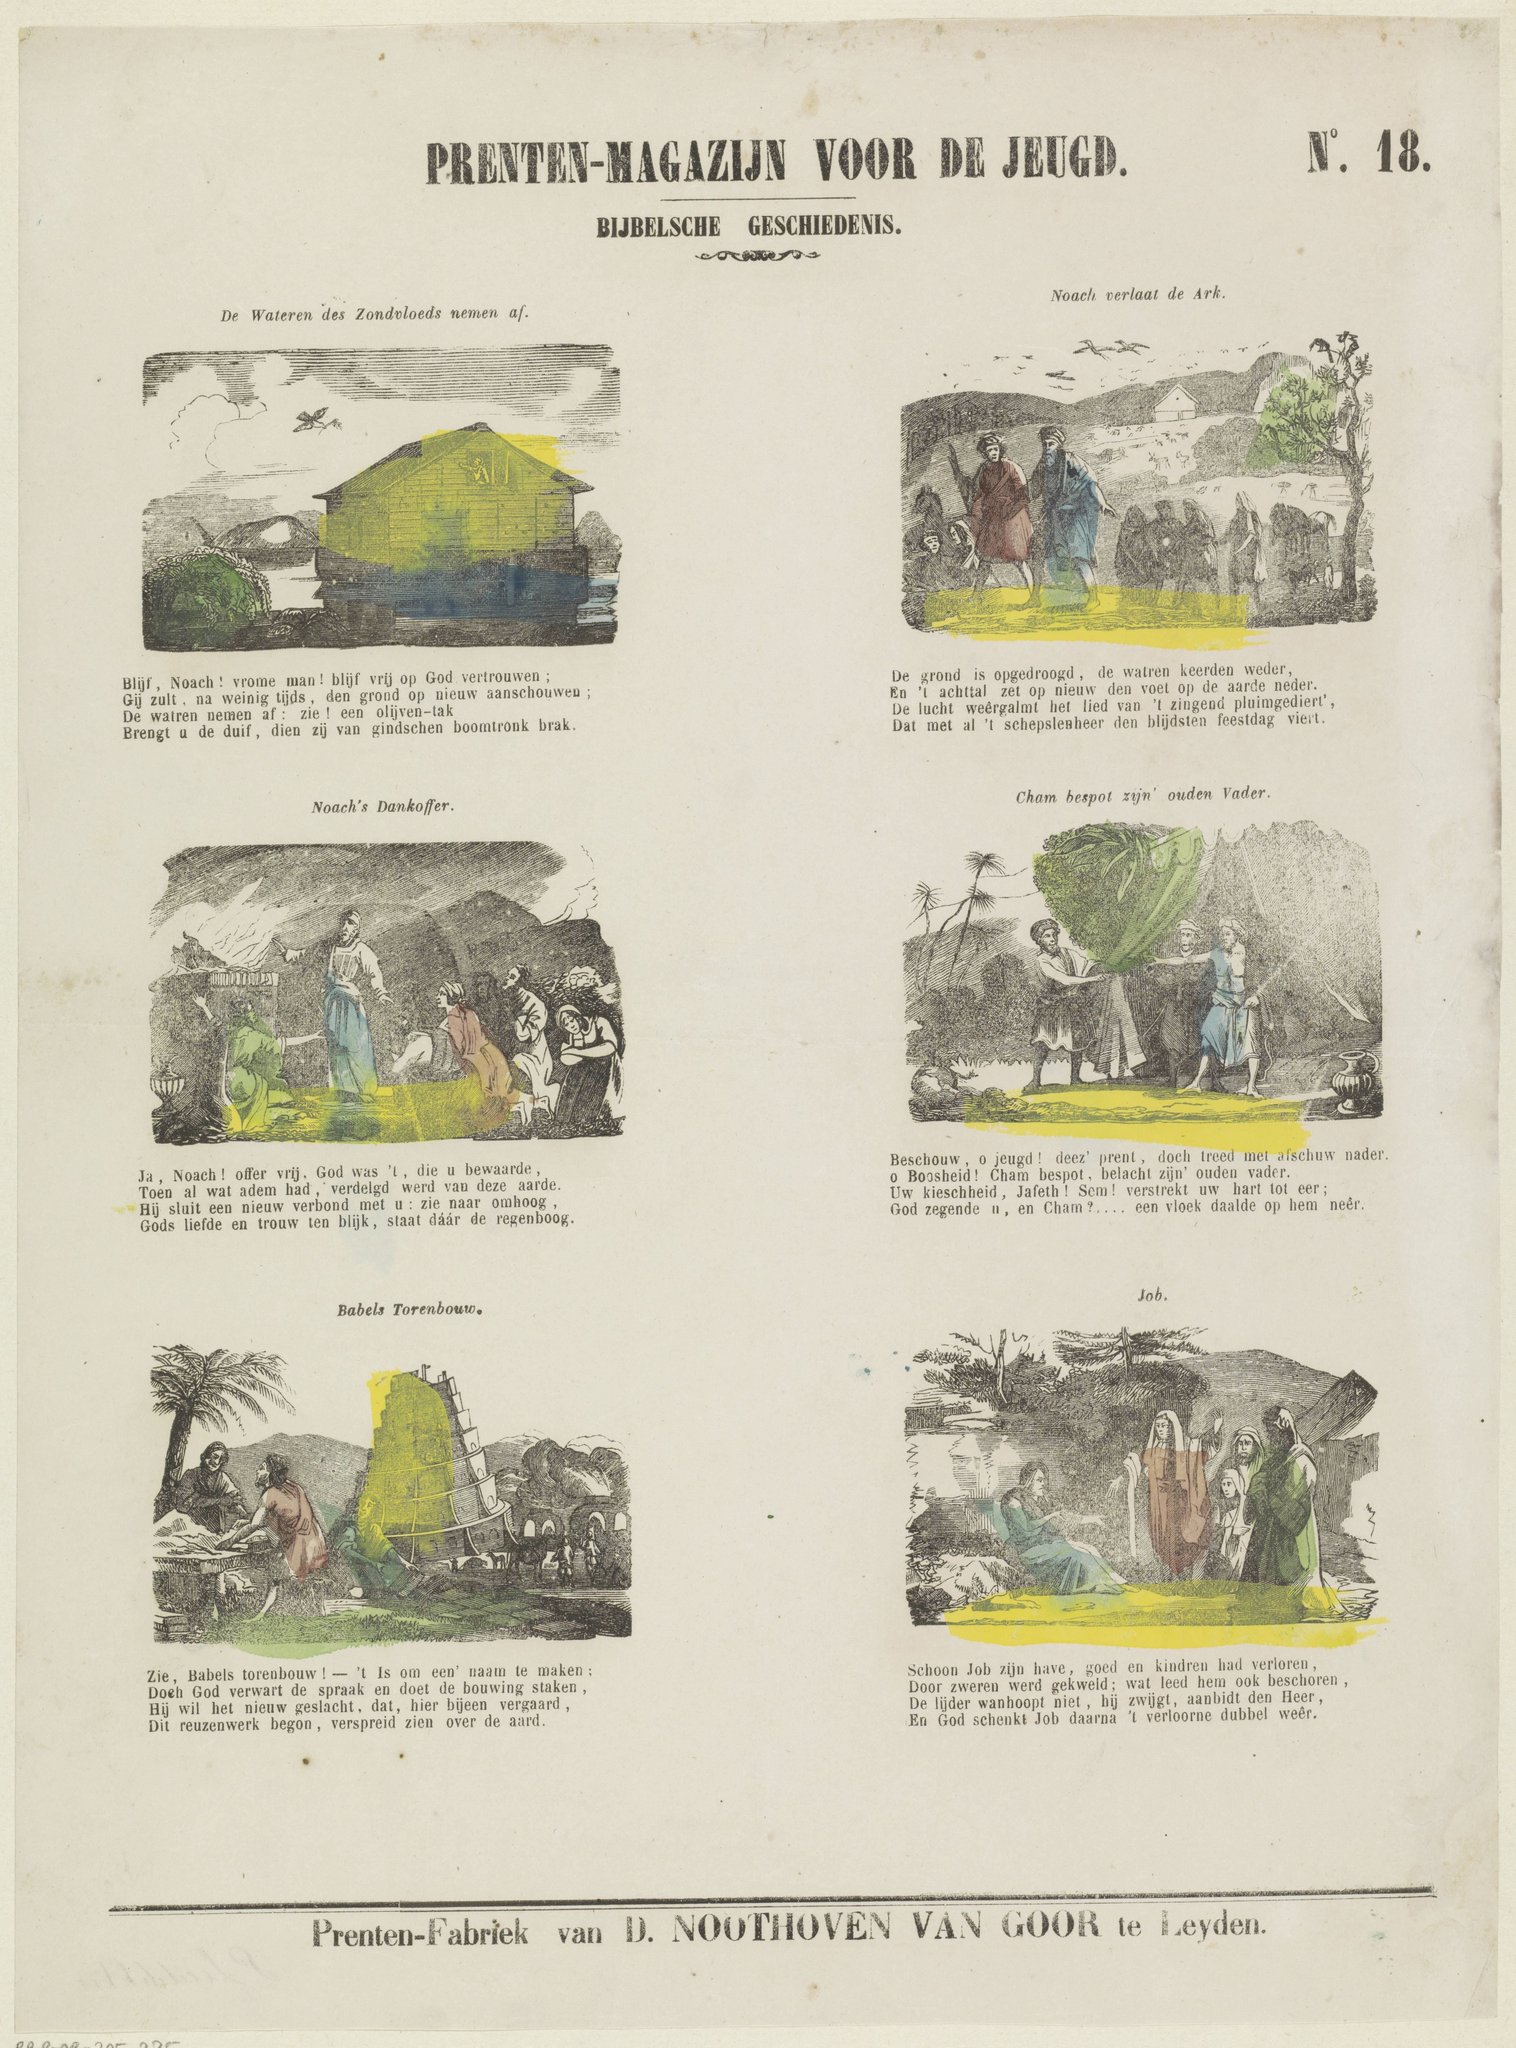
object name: print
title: Prenten-magazijn voor de jeugd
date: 1850-1881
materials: paper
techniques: colour, letterpress printing, engraving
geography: leiden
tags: job's former wealth is doubled, the tower of babel, story of noah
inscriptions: inscription: ‘P Leiddekker’, collector's mark: Lugt 2760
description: Blad met 6 voorstellingen van verhalen uit het Oude Testament, zoals Noach die de ark verlaat en de bouw van de Toren van Babel. Boven elke voorstelling een titel en onder elke voorstelling een vierregelig vers. Genummerd rechtsboven: No. 18.